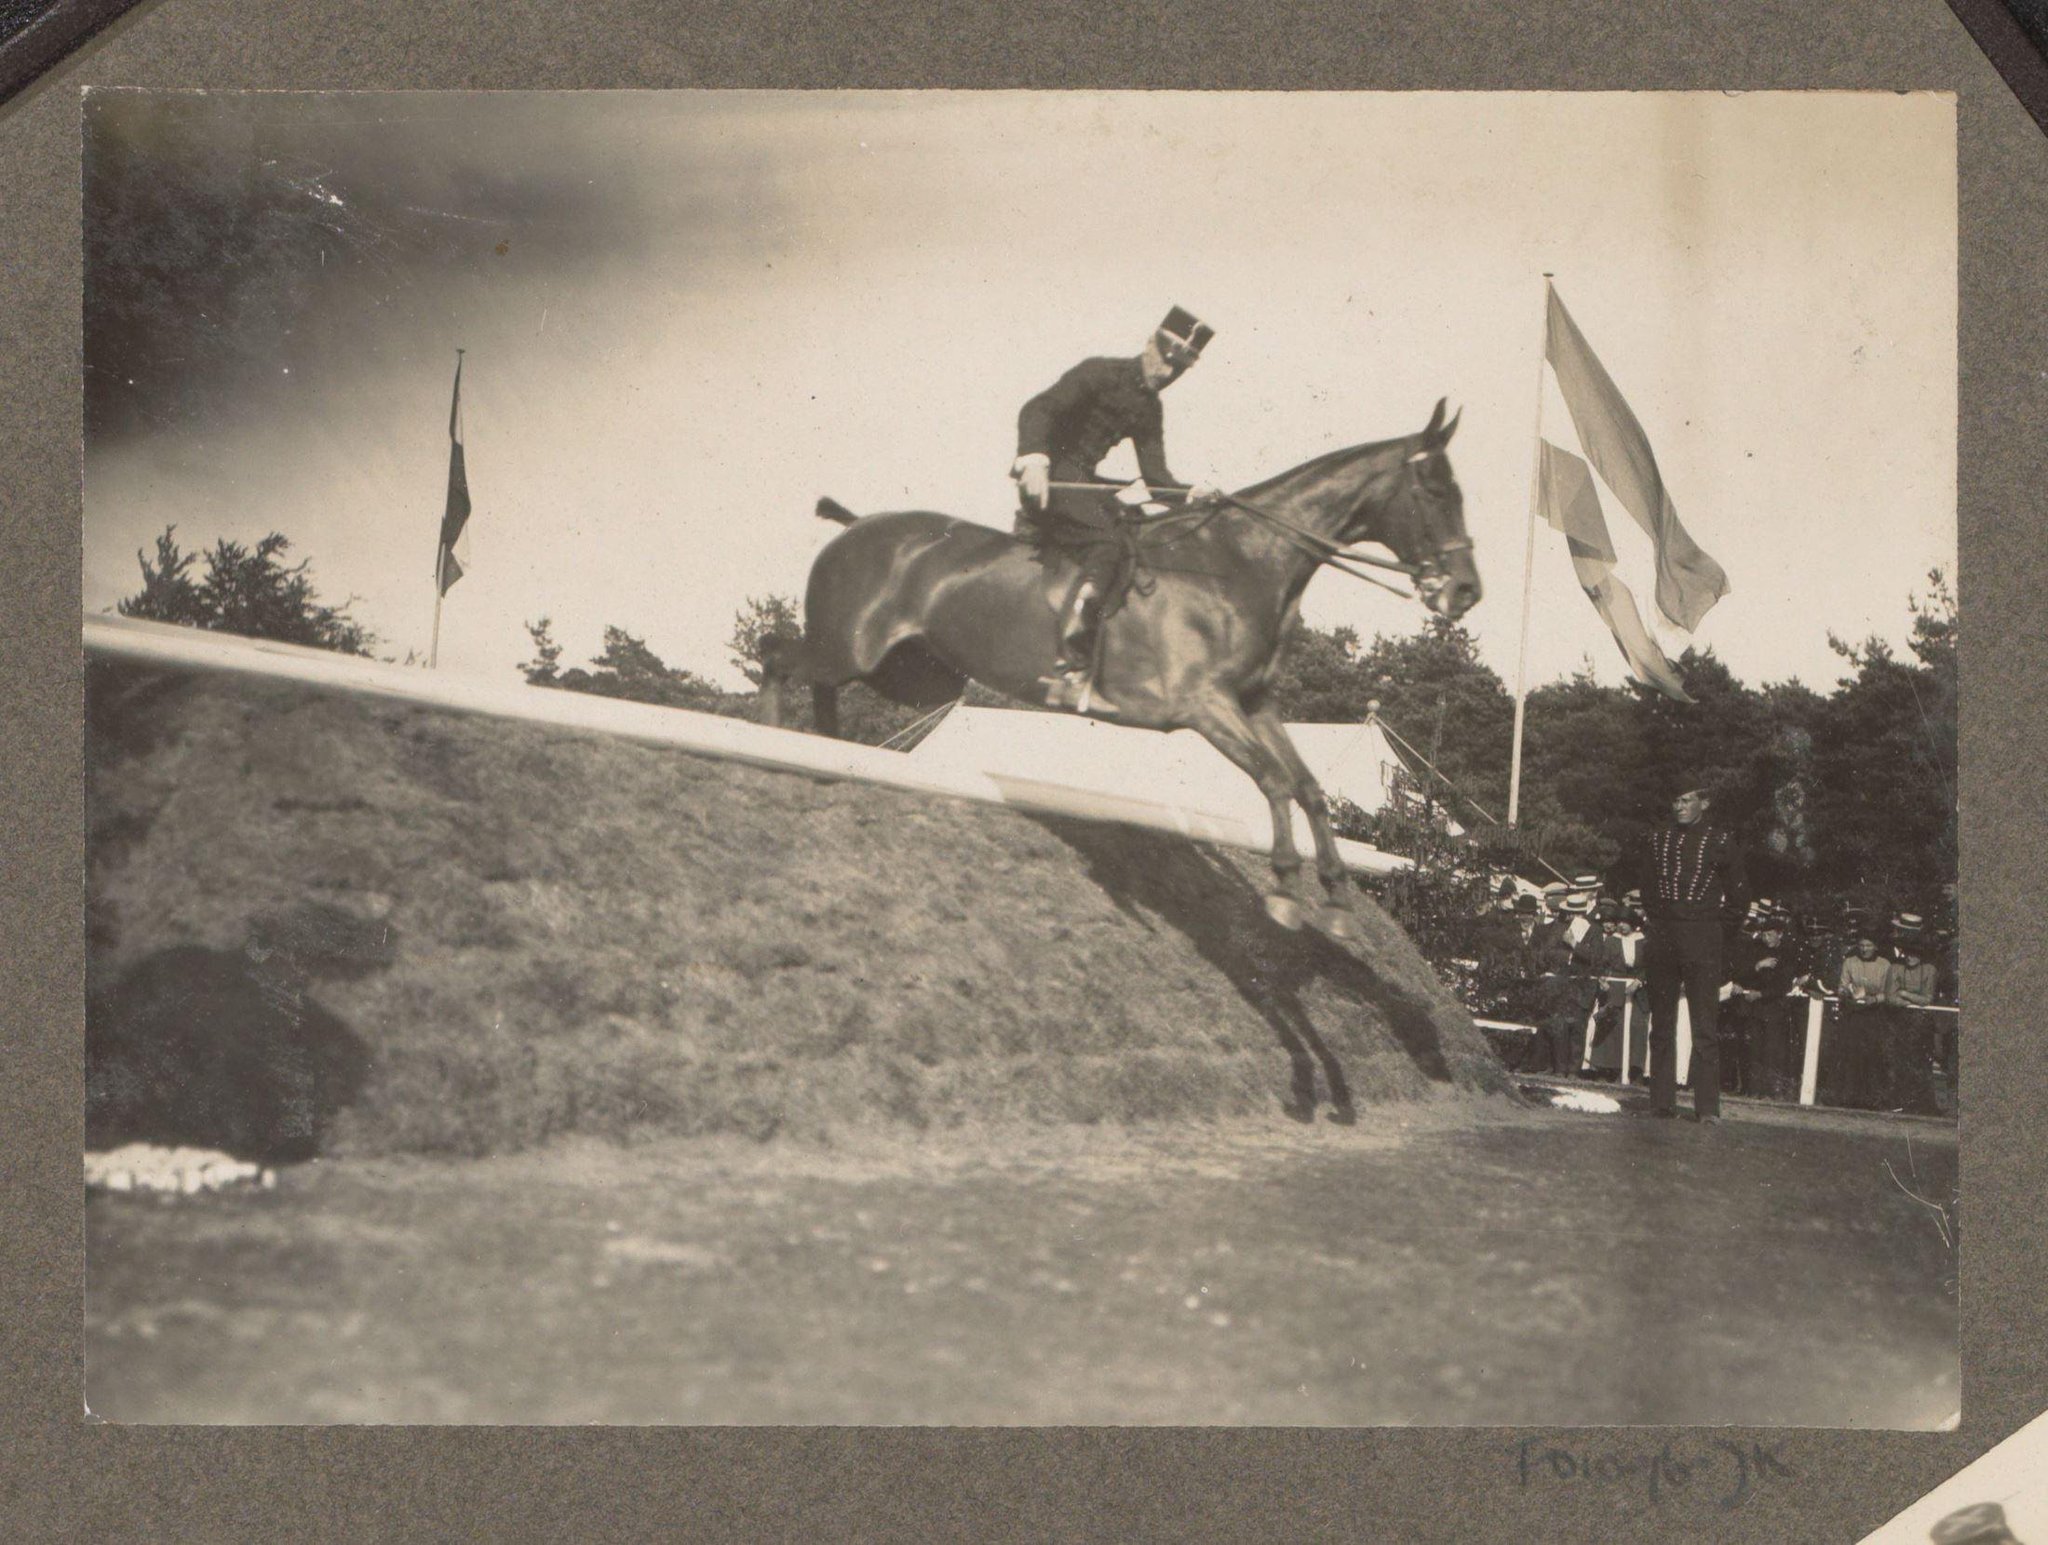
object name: album leaf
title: Ruitertafereel op Koninklijke Houtvesterij Het Loo: geüniformeerde ruiter neemt hindernis op een renbaan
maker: Anonymous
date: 1900-1925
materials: photographic support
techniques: gelatin silver print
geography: het loo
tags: riding a horse, ass, or mule; rider, horseman, hunting, chase, hunting-ground, horse-racing, jumping (horse in motion), (military) uniforms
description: Onderdeel van Fotoalbum van de heer Brams, opperhoutvester van koningin Wilhelmina op Koninklijke Houtvesterij Het Loo.